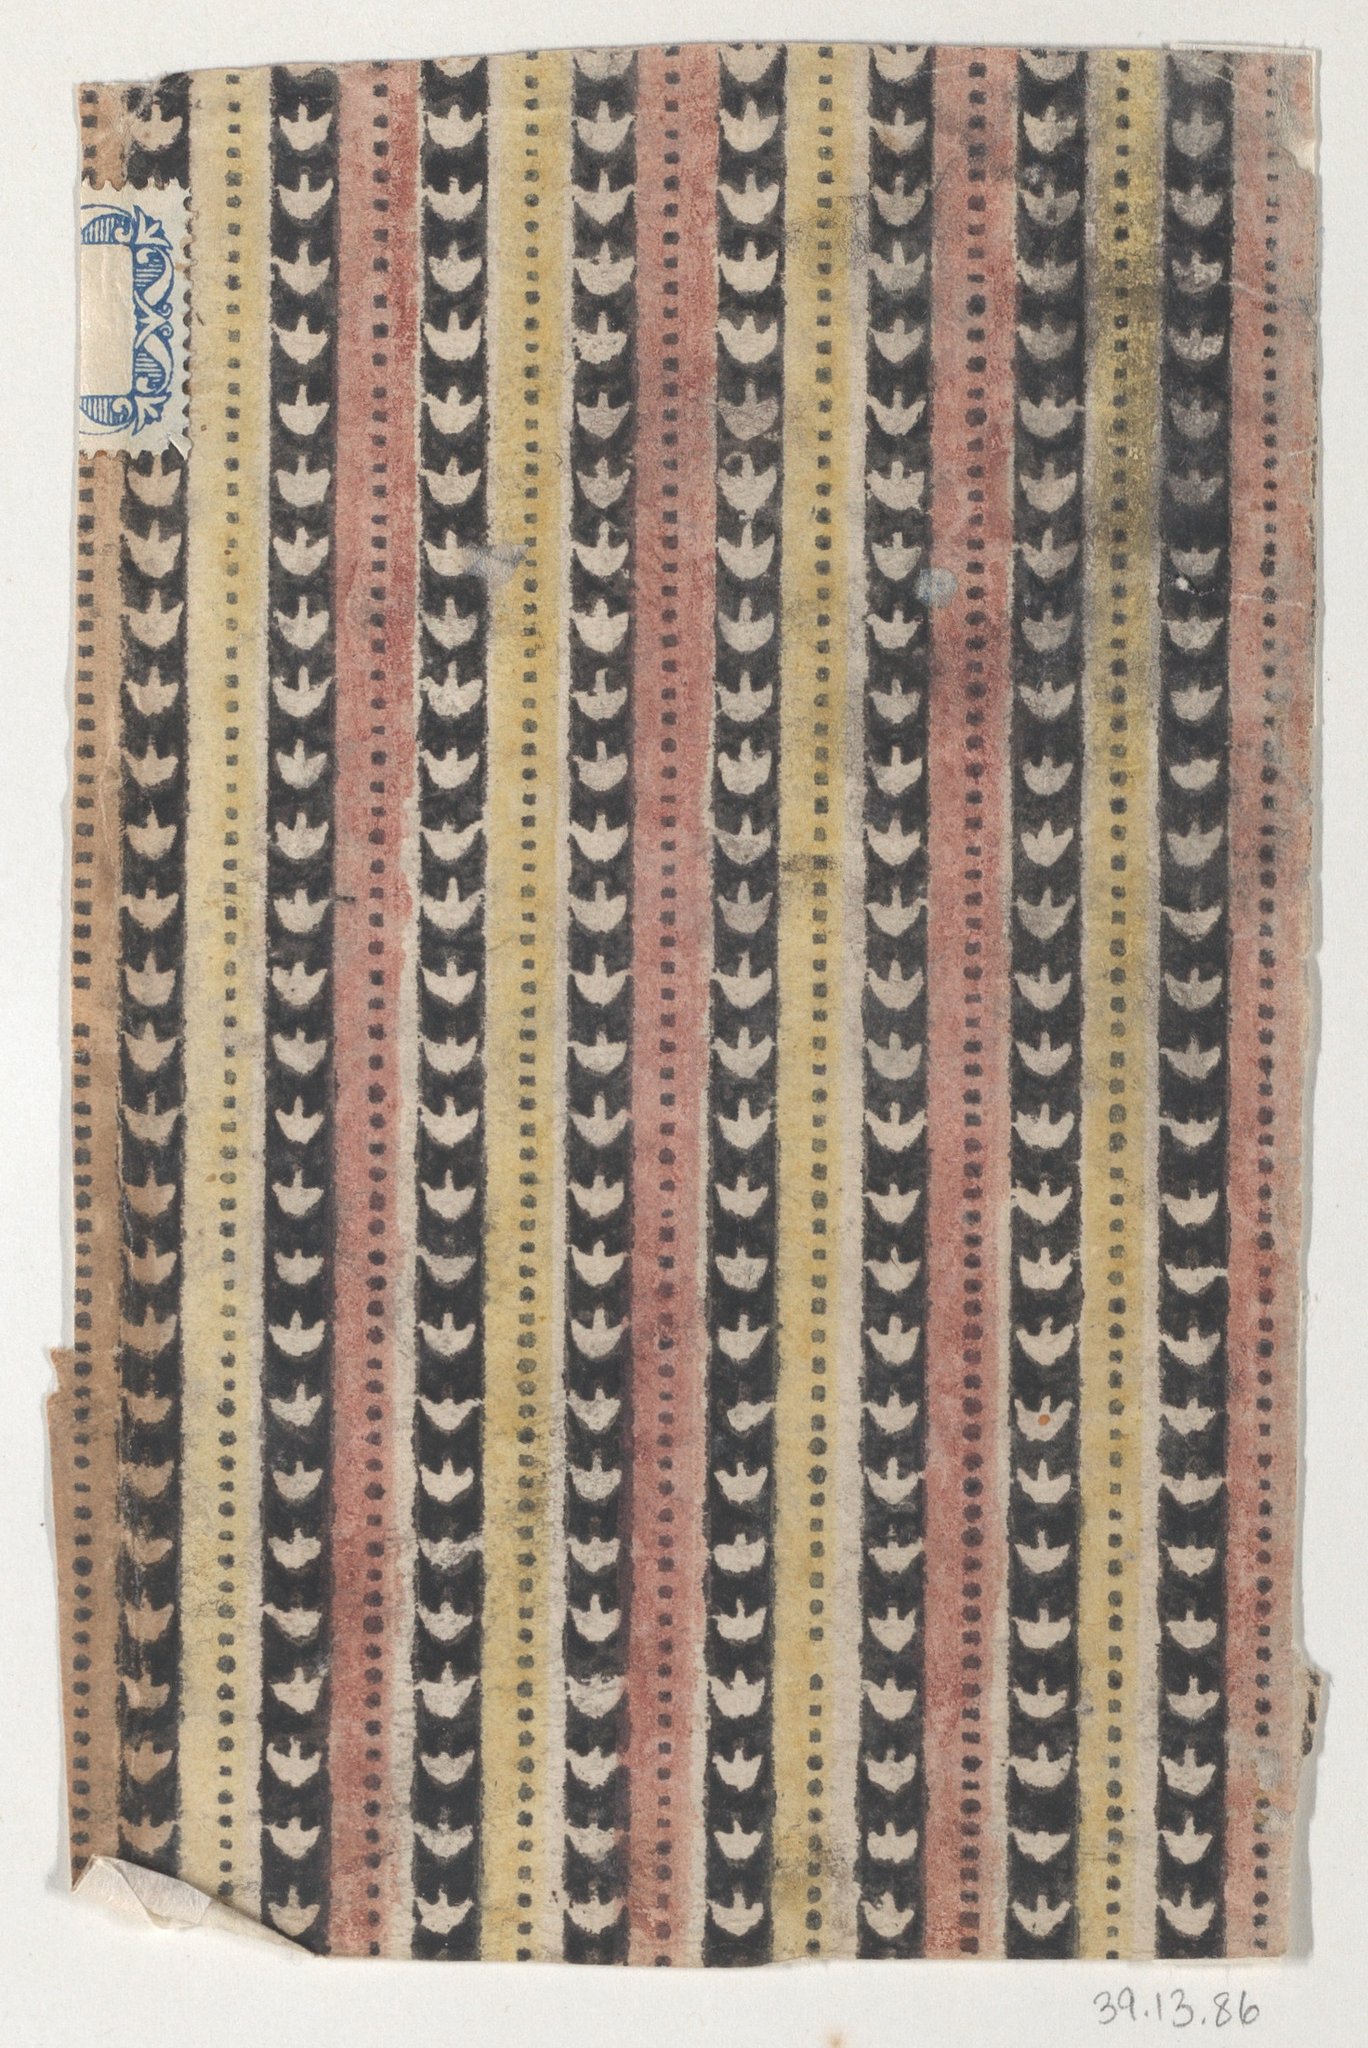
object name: print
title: Sheet with a striped and dot pattern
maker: Anonymous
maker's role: artist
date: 1767-1866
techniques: relief print